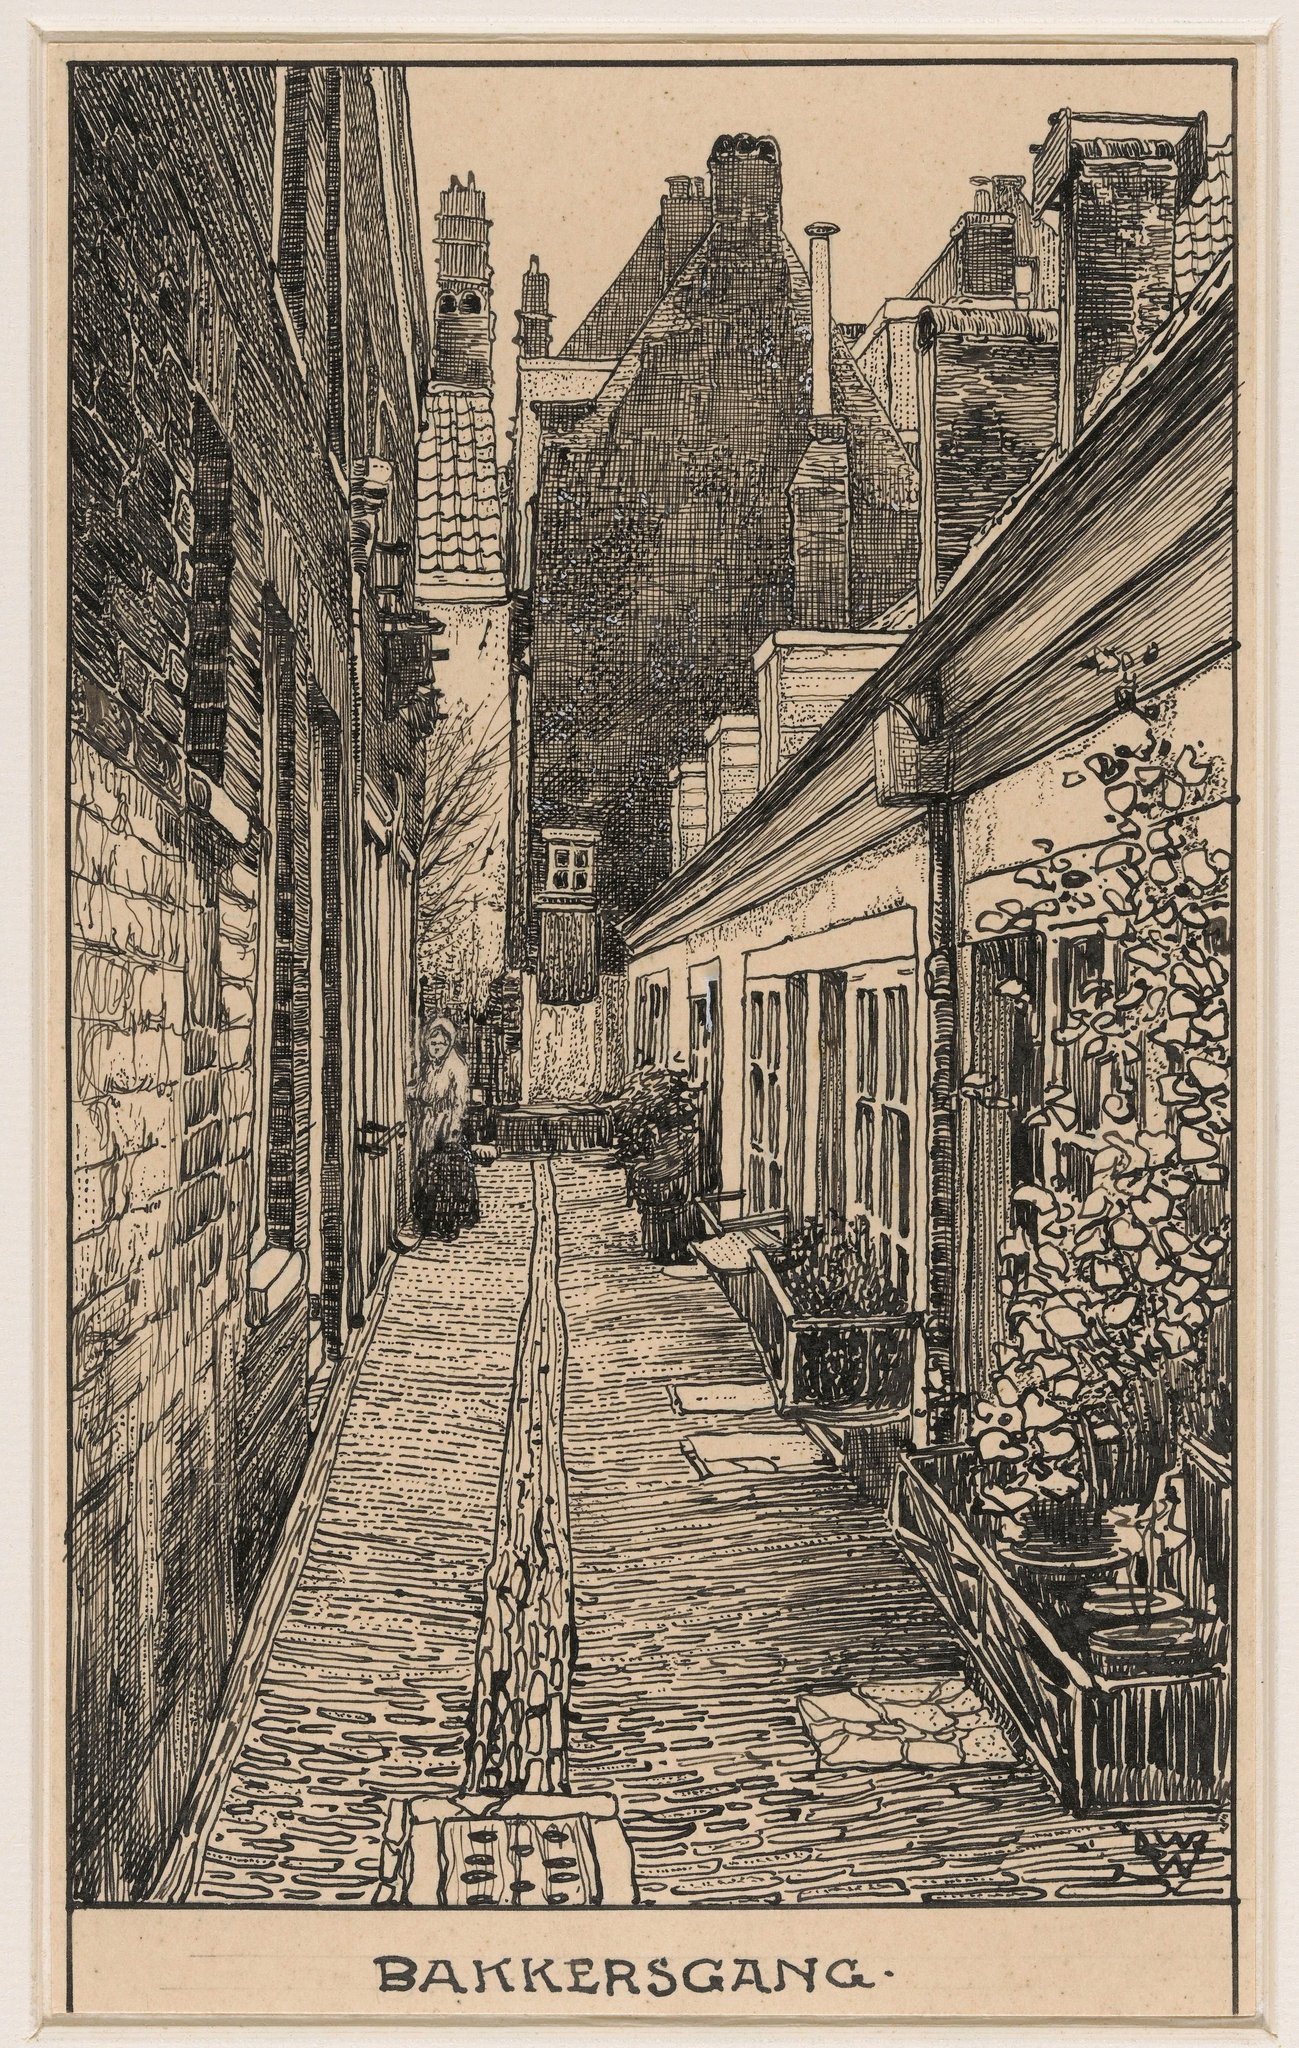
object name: drawing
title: Bakkersgang te Amsterdam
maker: willem wenckebach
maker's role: designer, draughtsman, painter, print maker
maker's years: 1860-1937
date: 1870-1926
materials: ink, paper, pencil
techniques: pen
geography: amsterdam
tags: lane, alley, amsterdam